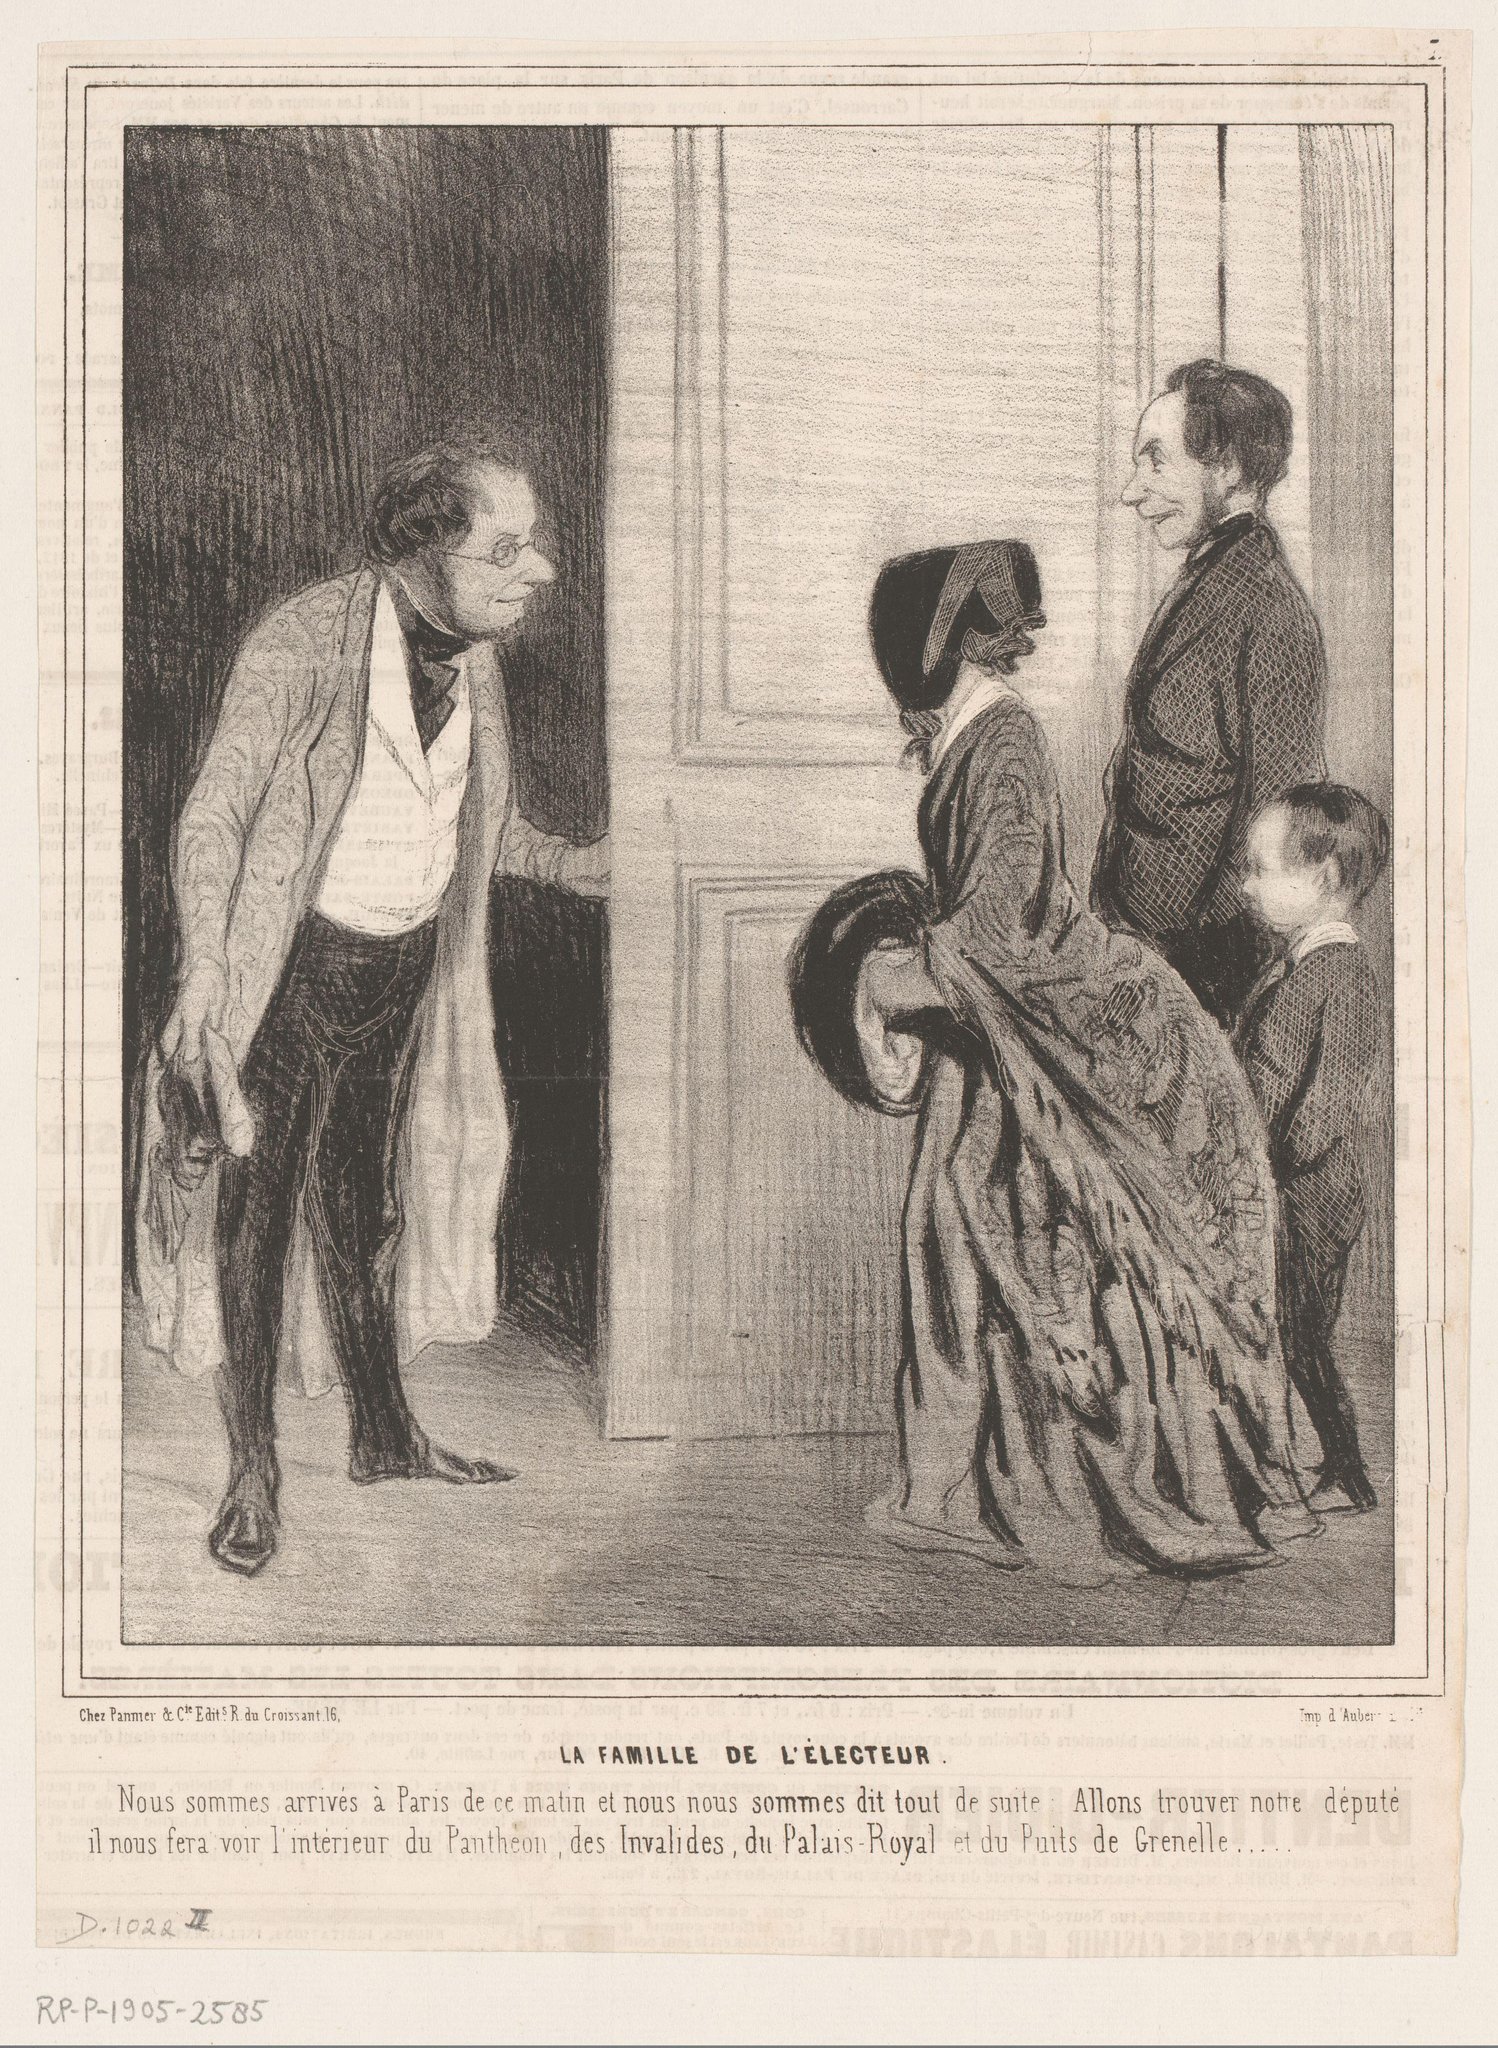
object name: cartoon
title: Scènes met parlementsleden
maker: honoré daumier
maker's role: draughtsman, painter, print maker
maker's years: 1808-1879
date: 1843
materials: paper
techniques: lithograph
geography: paris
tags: voting, election, caricatures (human types), political caricatures and satires, paris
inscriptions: collector's mark: Lugt 2228a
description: Een parlementslid ontvangt een invloedrijke kiezer met diens gezin. Zij hebben gehoord dat het parlementslid hen een rondleiding door diverse regeringsgebouwen in Parijs kan geven.